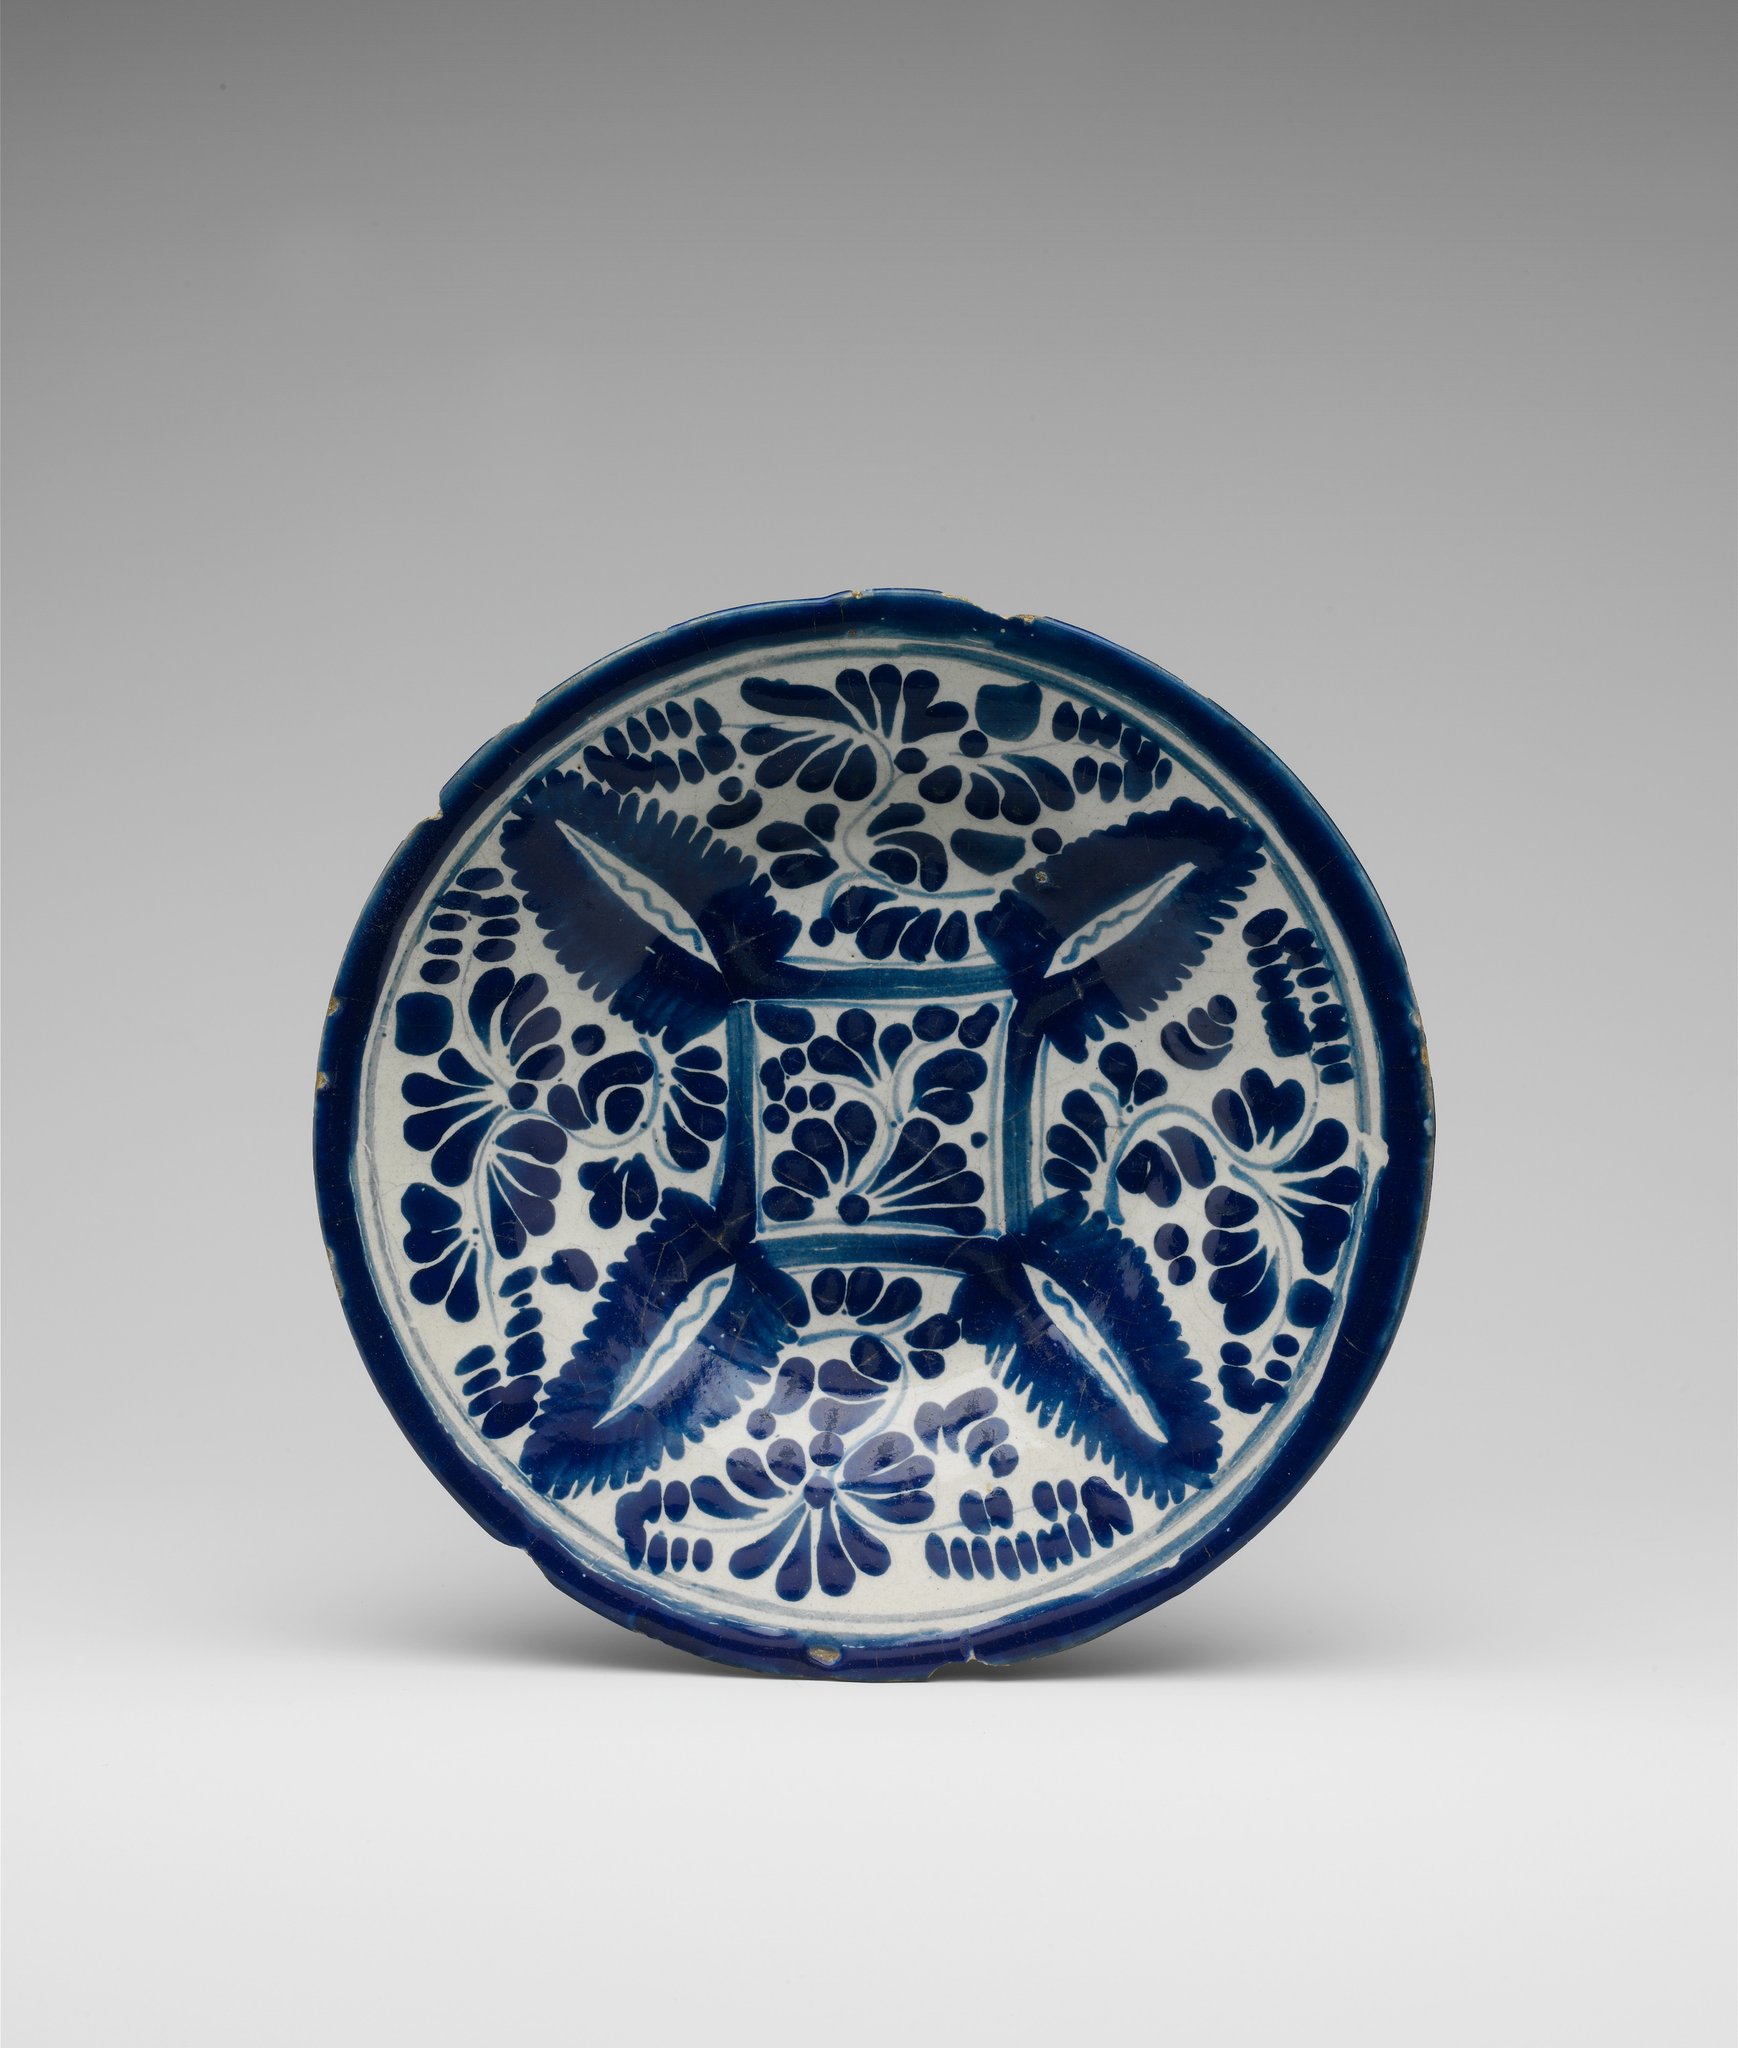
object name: plate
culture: mexican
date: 1800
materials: earthenware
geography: mexico